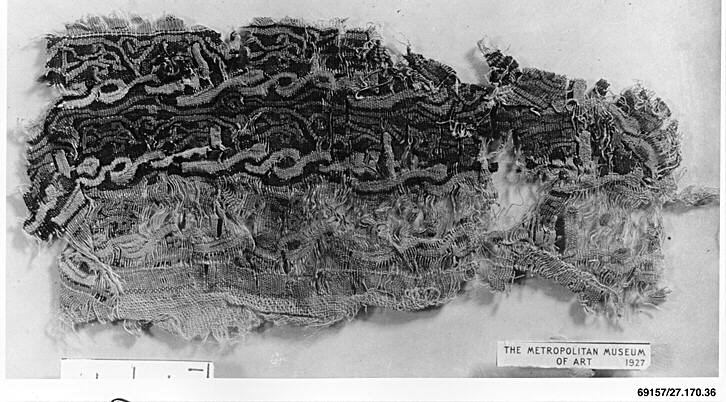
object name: textile fragment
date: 1101-1200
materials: linen, silk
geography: egypt